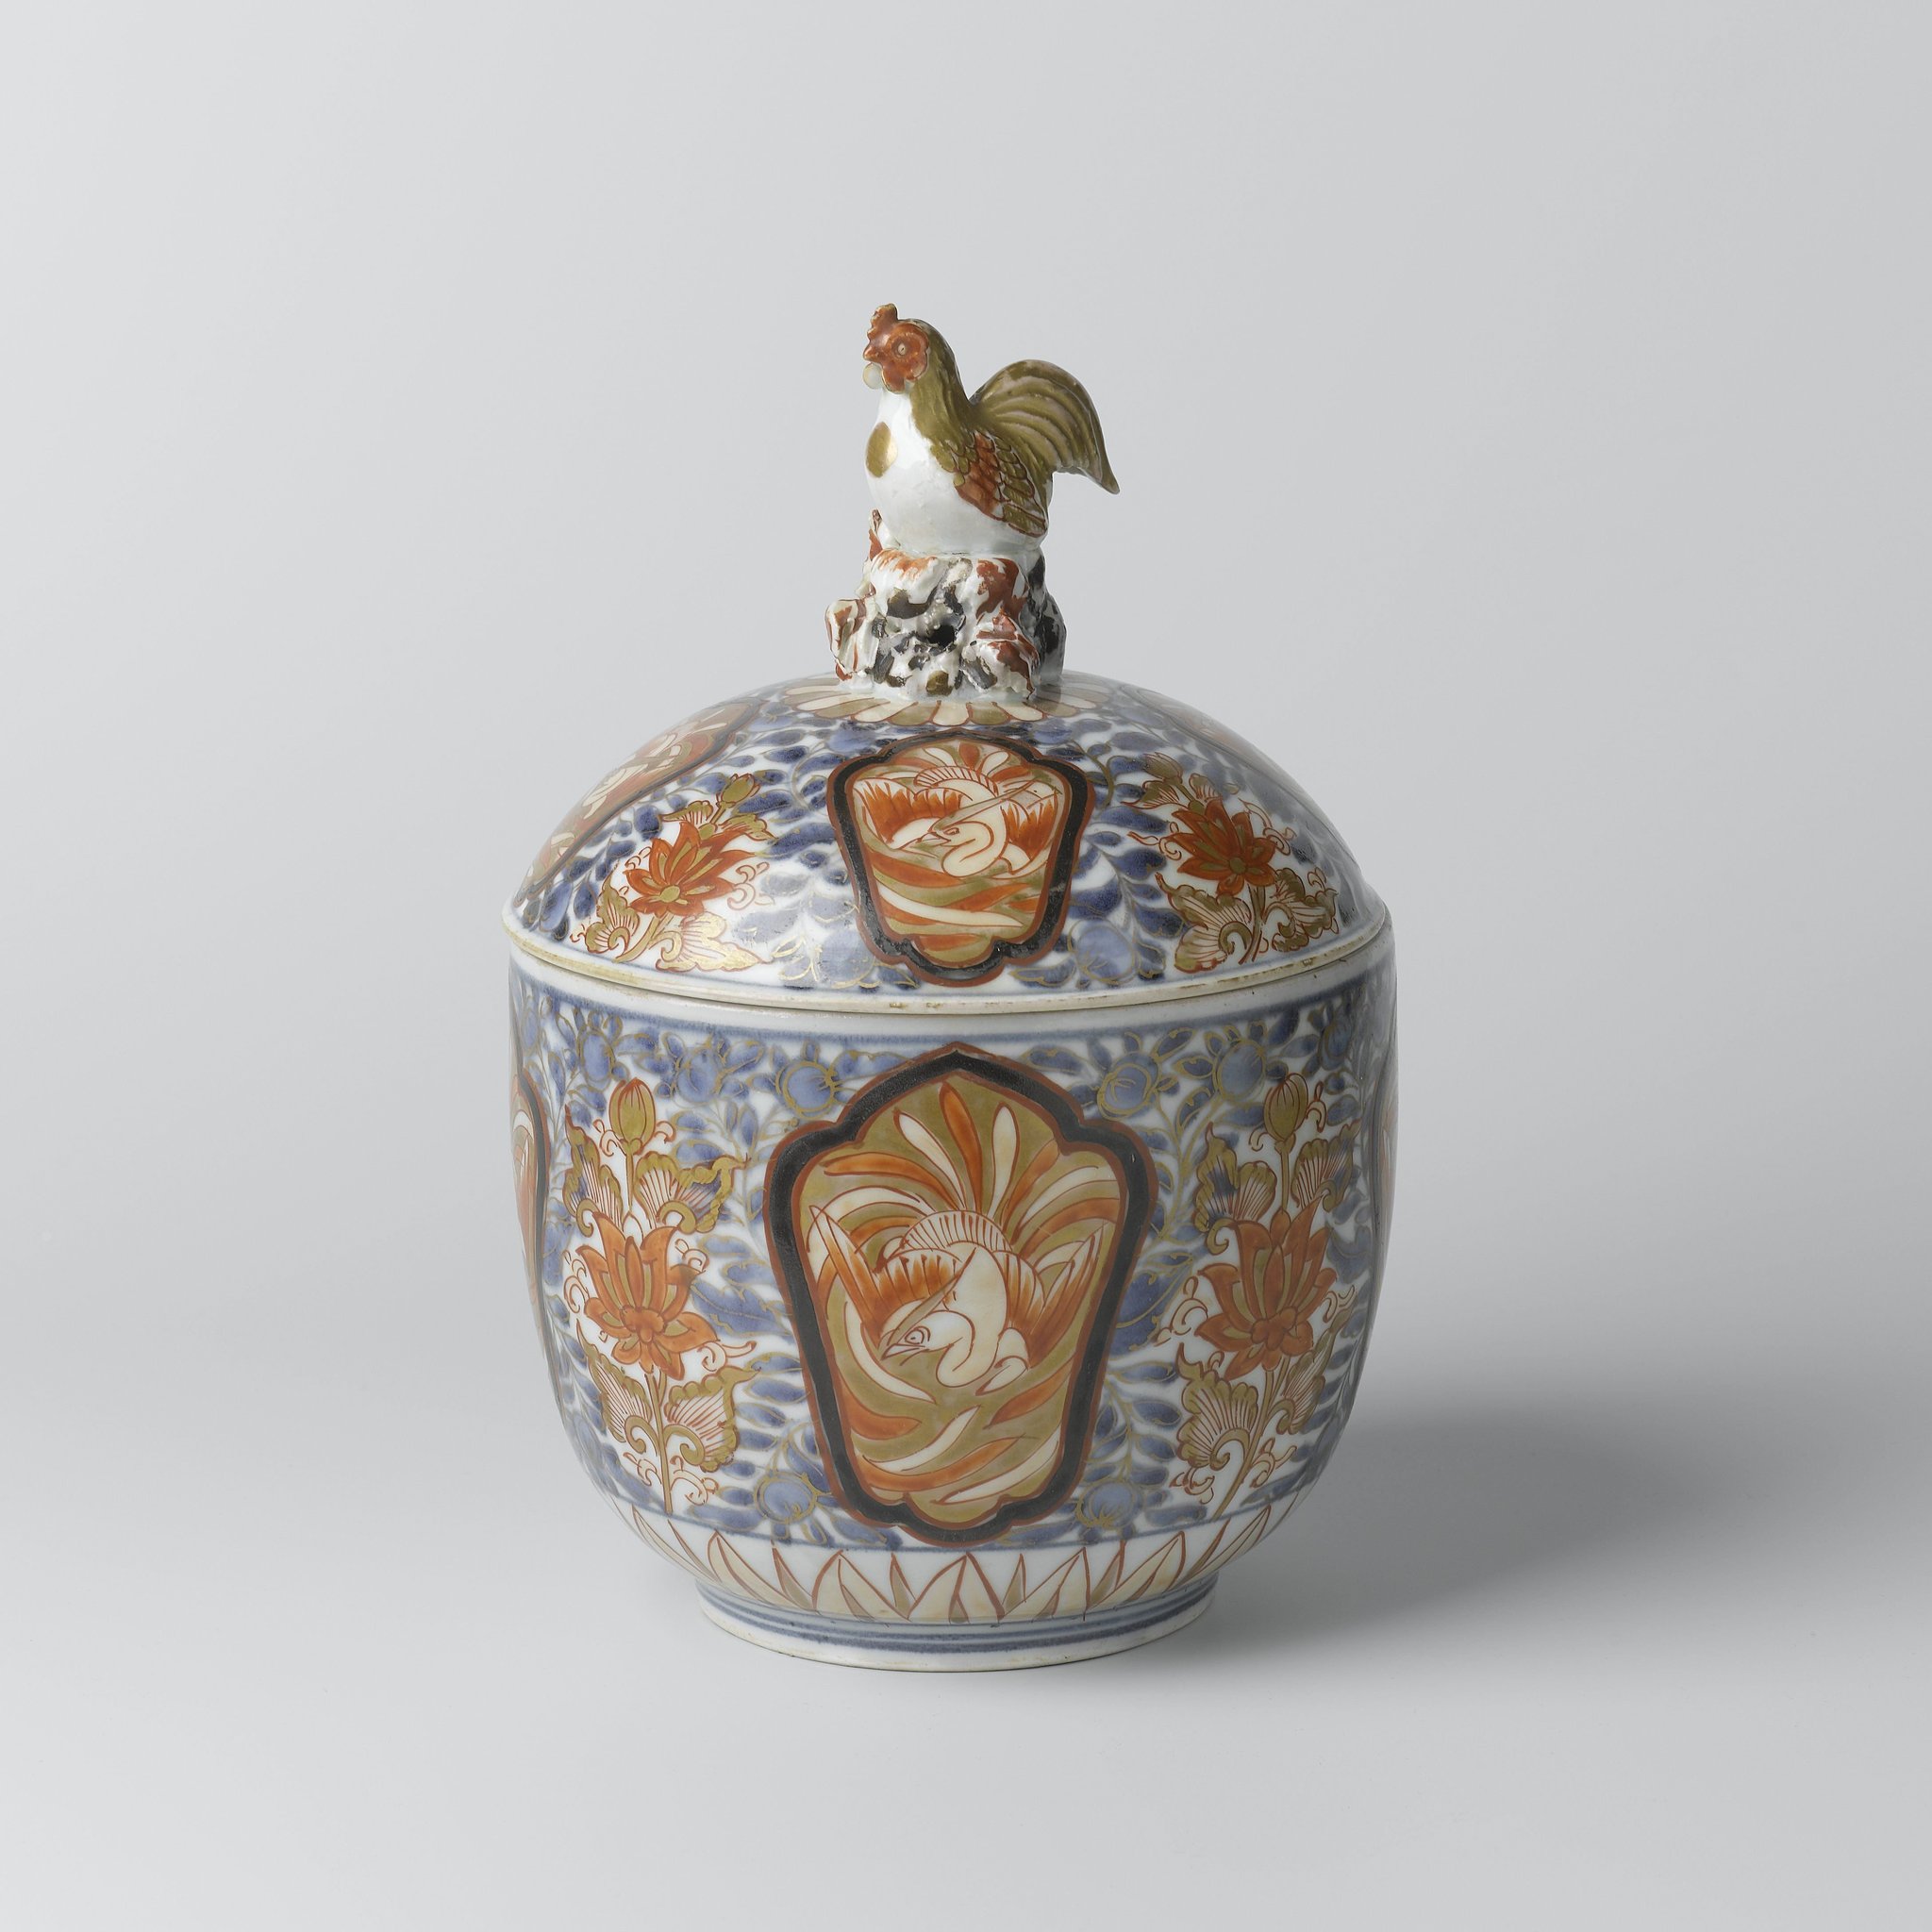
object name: covered jar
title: Covered jar with hoo-birds in panels on a ground of lotus and floral scrolls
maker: Anonymous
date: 1720-1770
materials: cobalt, glaze, gold, paint, porcelain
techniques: firing, gilding, turning, vitrification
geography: japan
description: Dekselpot van porselein, beschilderd in onderglazuur blauw en op het glazuur rood, zwart en goud. Op de buitenwand bloemranken met hierin uitgespaard afwisselend een lotusrank en een cartouche met een hoo-vogel. Rond de voet een band met puntige bladmotieven. De deksel met dezelfde decoratie; dekselknop in de vorm van een haan op een rots. Imari.